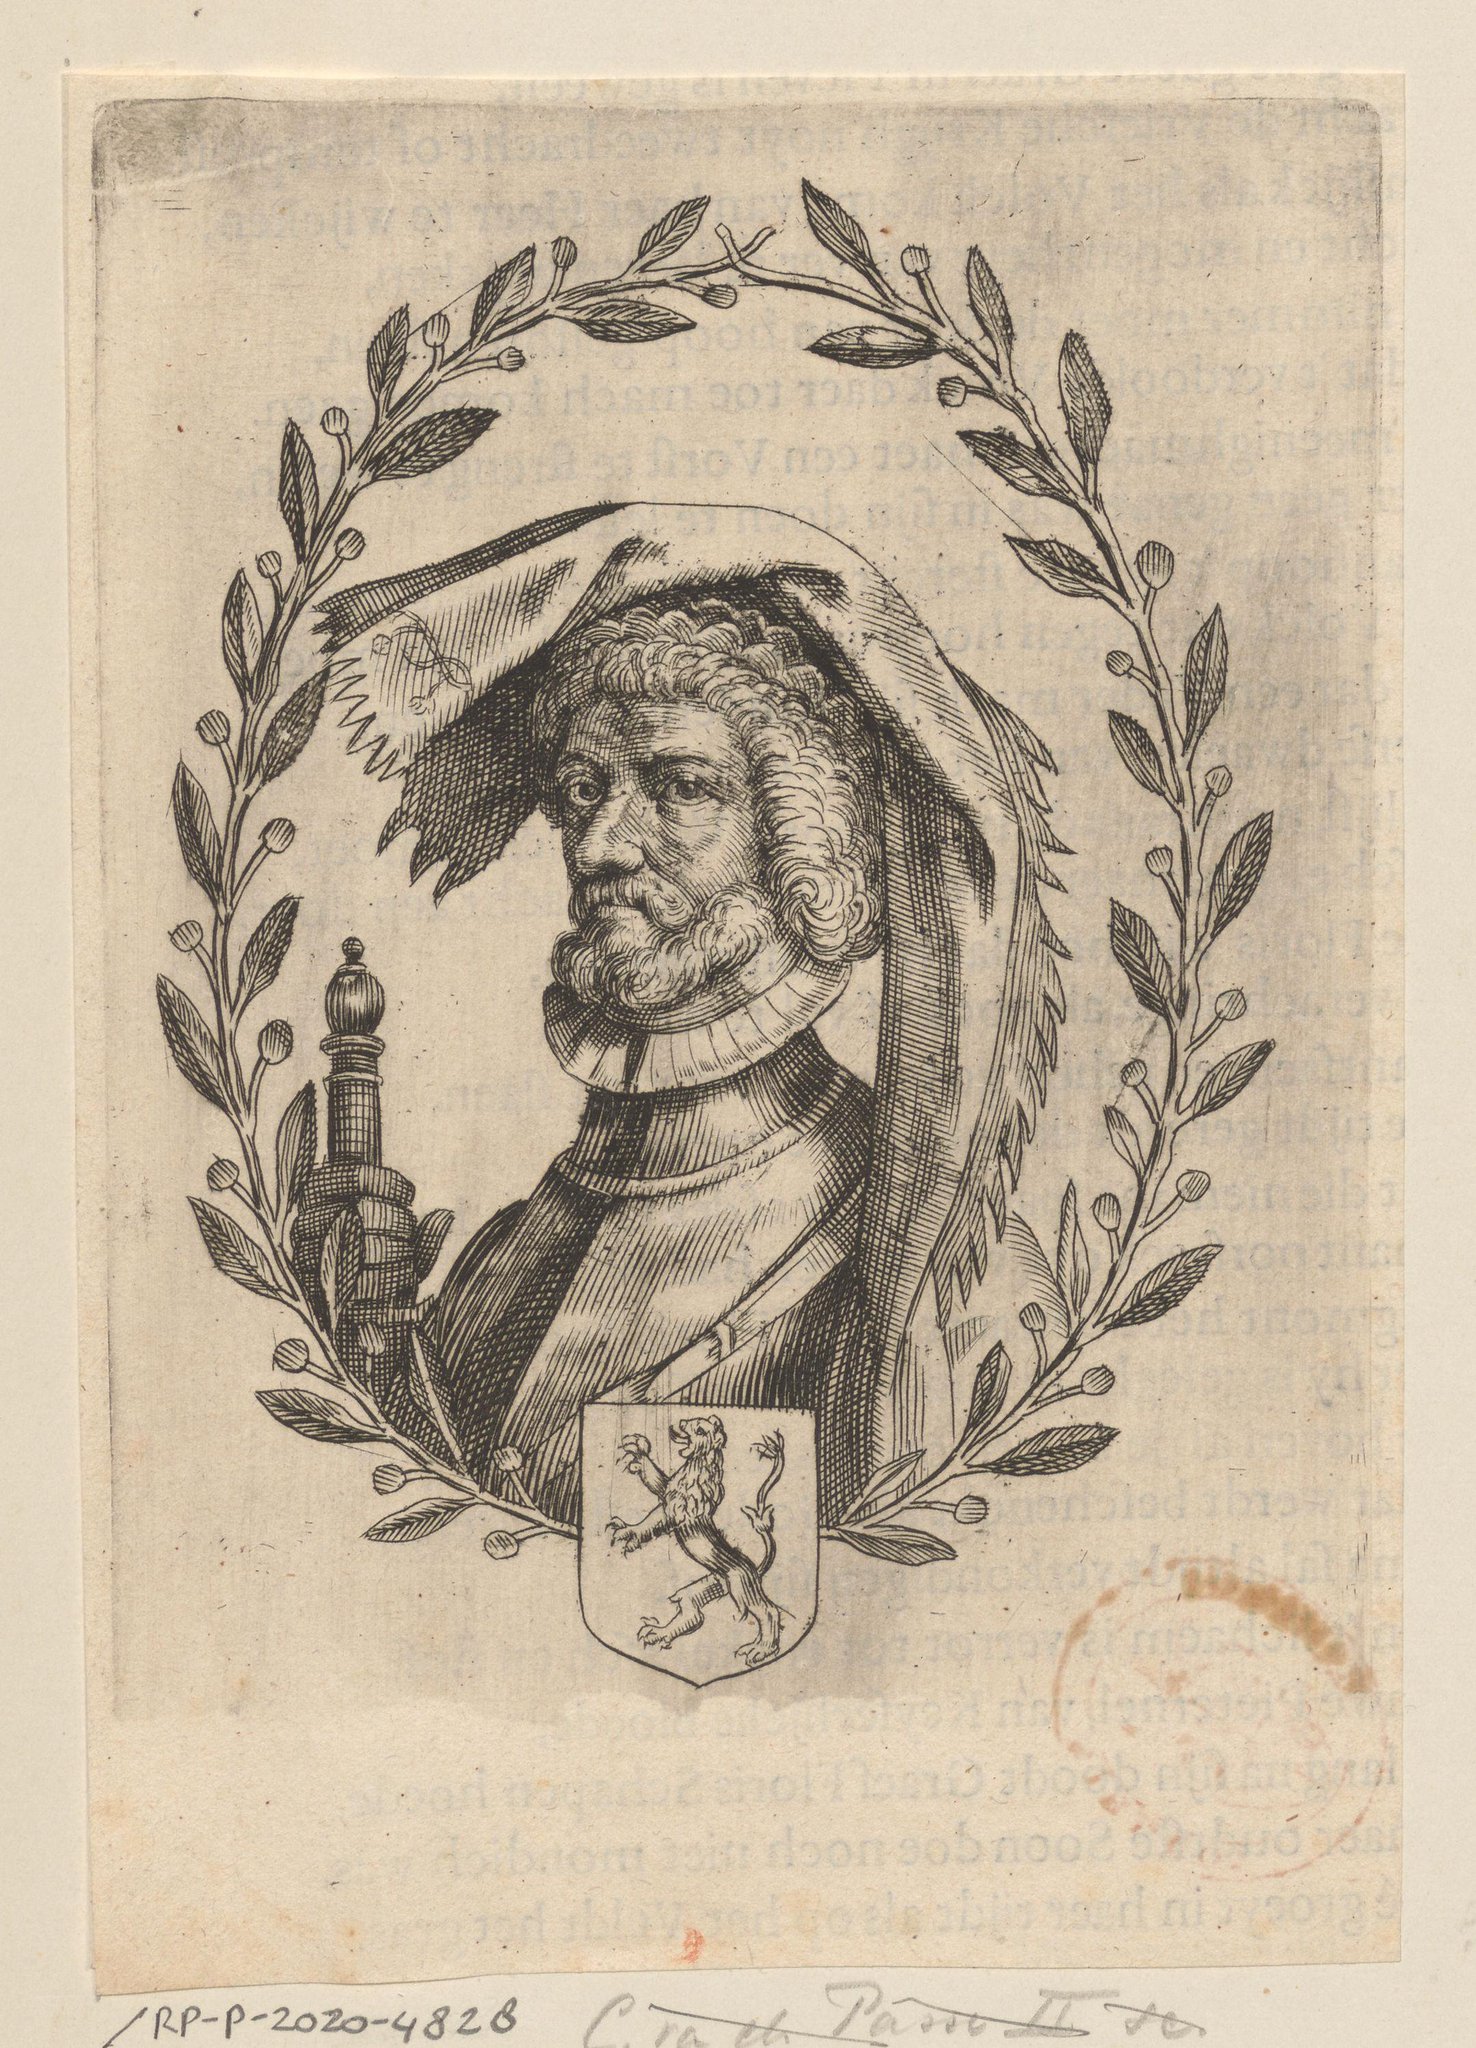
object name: book illustration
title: Portret van Dirk VI, graaf van Holland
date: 1645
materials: paper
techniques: engraving, intaglio, letterpress printing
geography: amsterdam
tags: historical persons, head-gear (with name), ruler, sovereign, armorial bearing, heraldry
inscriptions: collector's mark: Lugt 240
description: Prent uit: Wachtendorp, Caspar. Oude Hollandsche geschiedenissen ofte, korte Hollandtsche rym-kronyck. 14 dln. Amsterdam: Johannes Pauli, 1645, dl. 1.